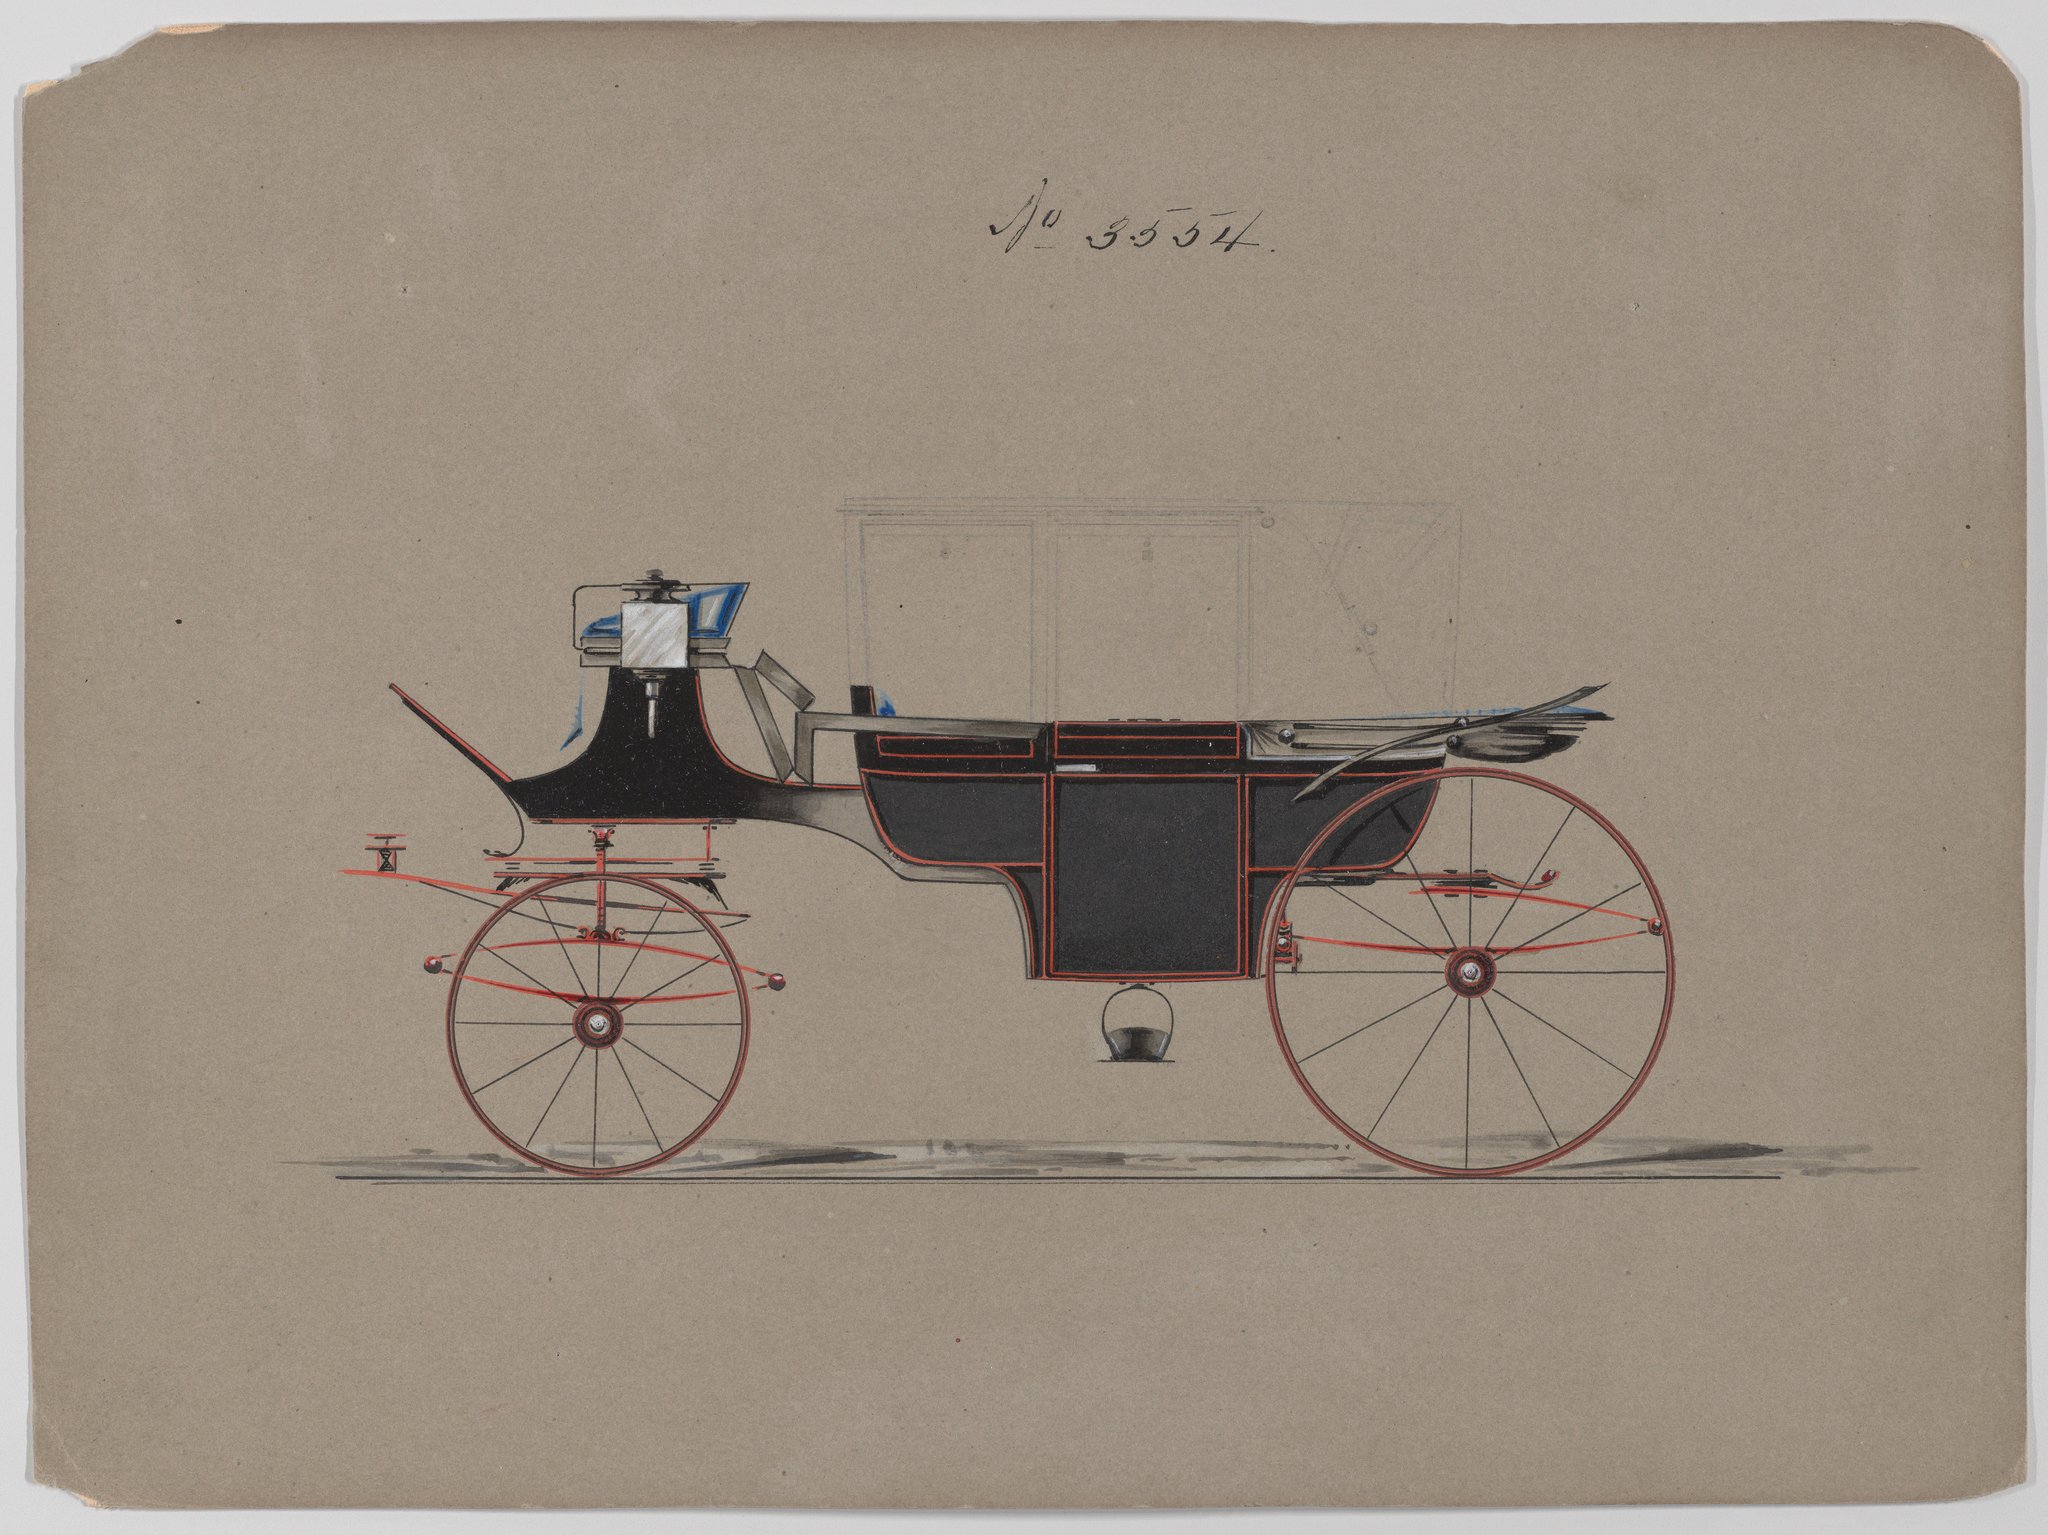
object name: drawing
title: Design for Landau, No. 3554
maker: brewster & co.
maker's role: manufacturer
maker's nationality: american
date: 1879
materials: gouache, gum arabic, ink, watercolor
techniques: pen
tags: carriages